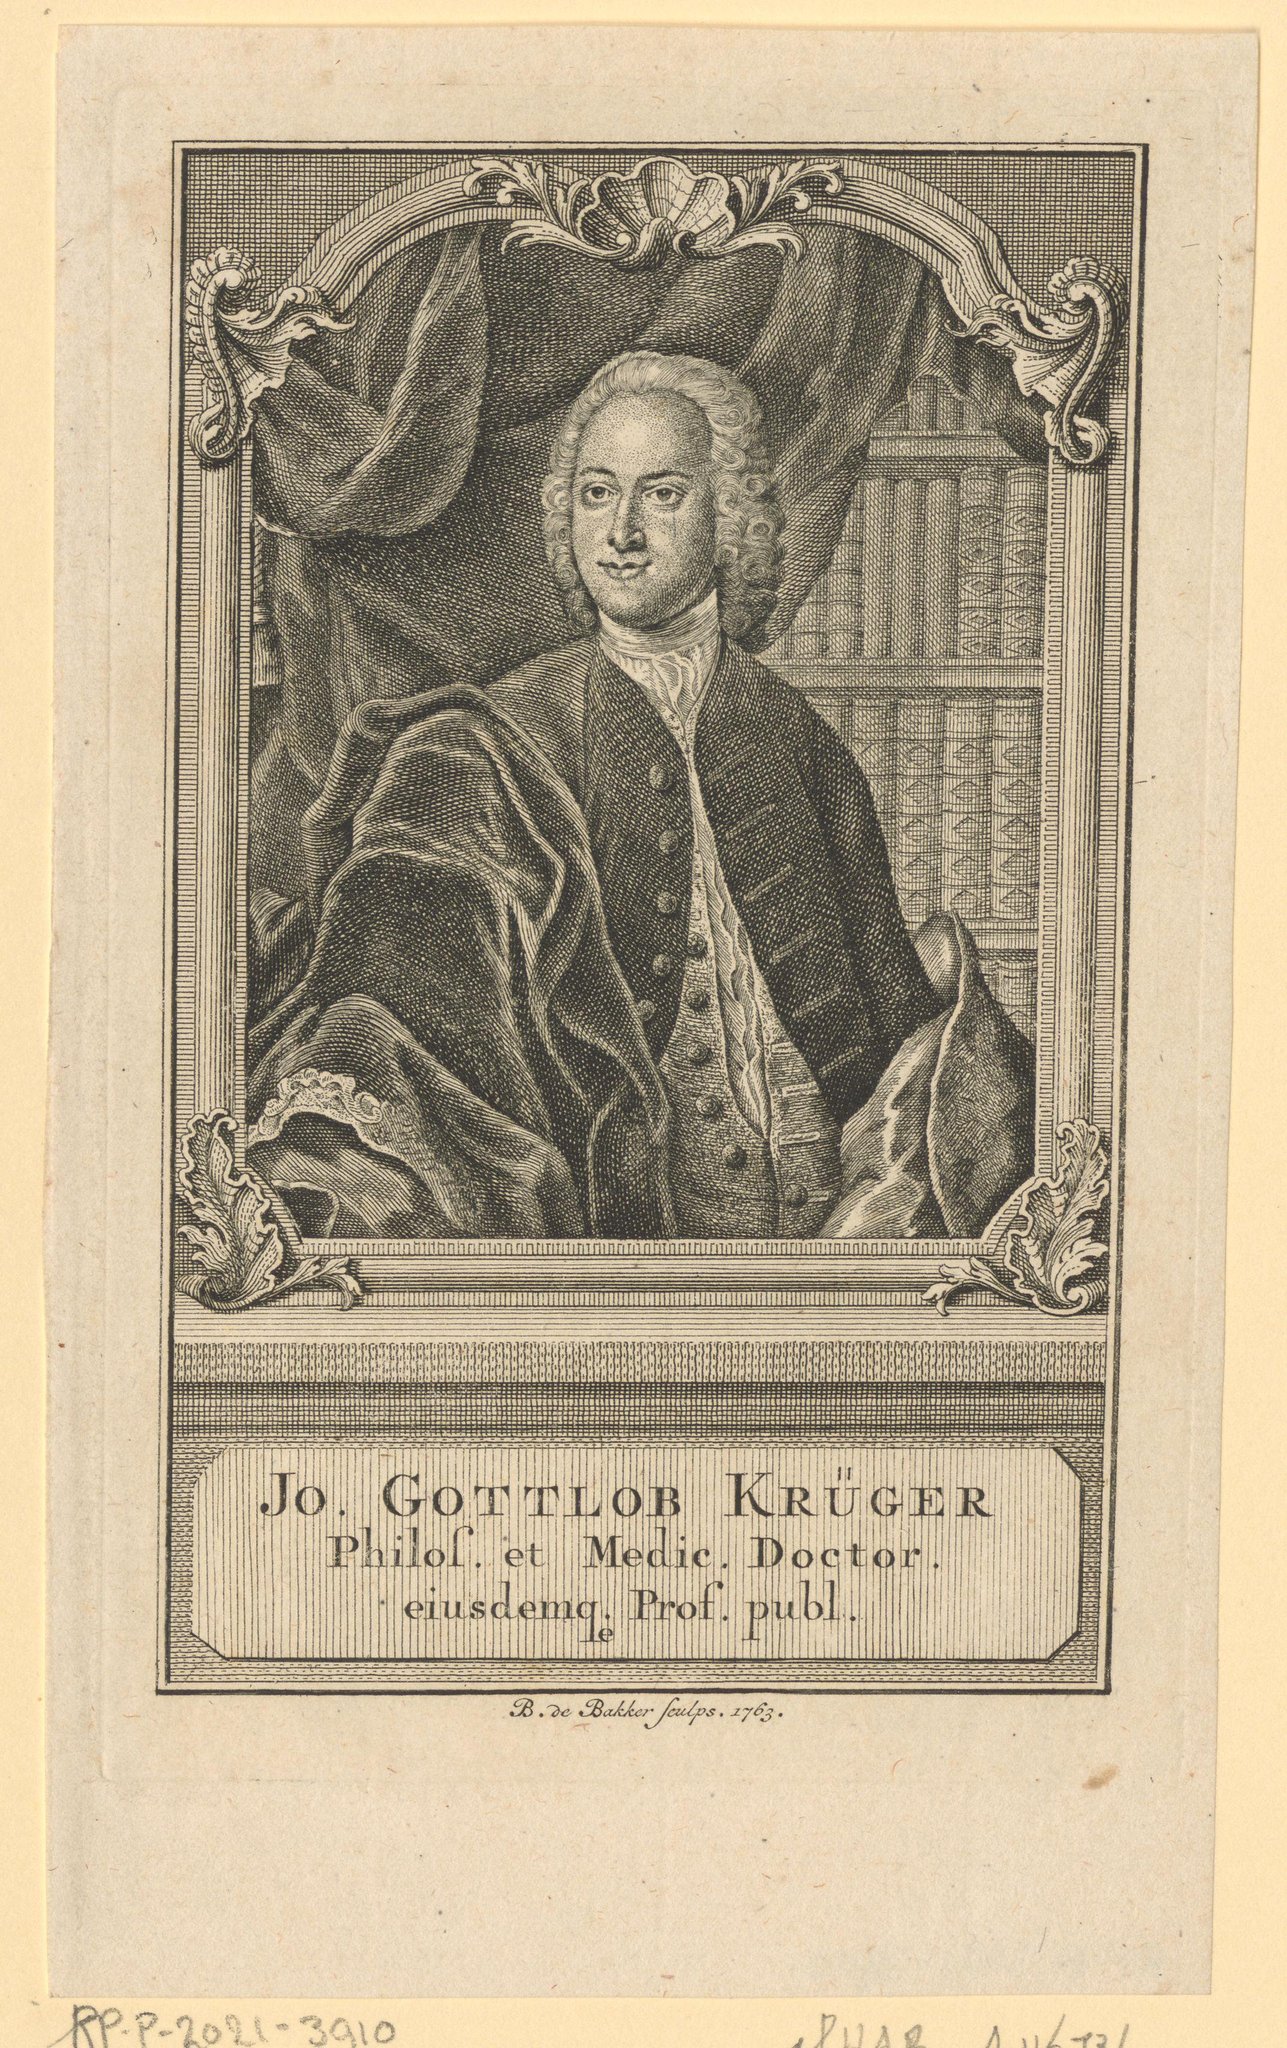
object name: print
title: Portret van Johann Gottlob Krüger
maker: barent de bakker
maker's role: print maker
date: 1763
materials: paper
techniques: etching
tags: historical persons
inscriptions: date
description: Prent mogelijk uit: Krüger, Johann Gottlob. Physiologia, of Natuurkundige verhandeling over het leven (...). Amsterdam: Jan Morterre, 1763, dl. 1.